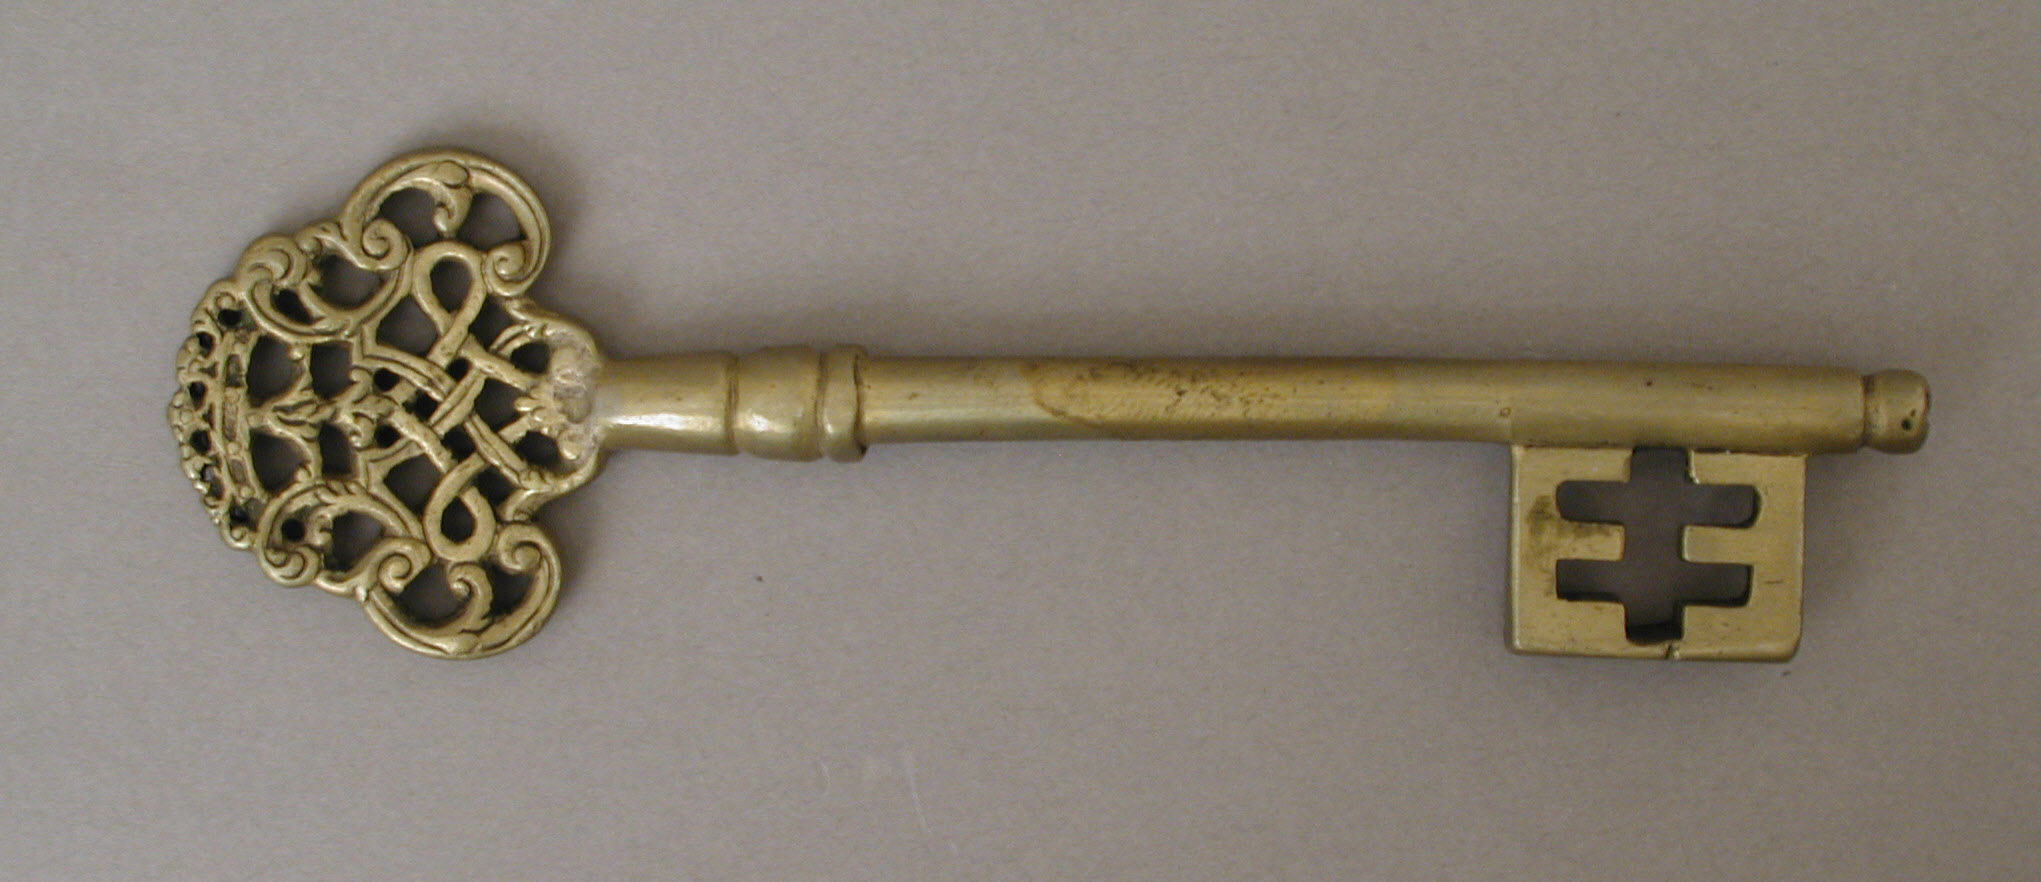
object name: key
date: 1600-1620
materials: brass